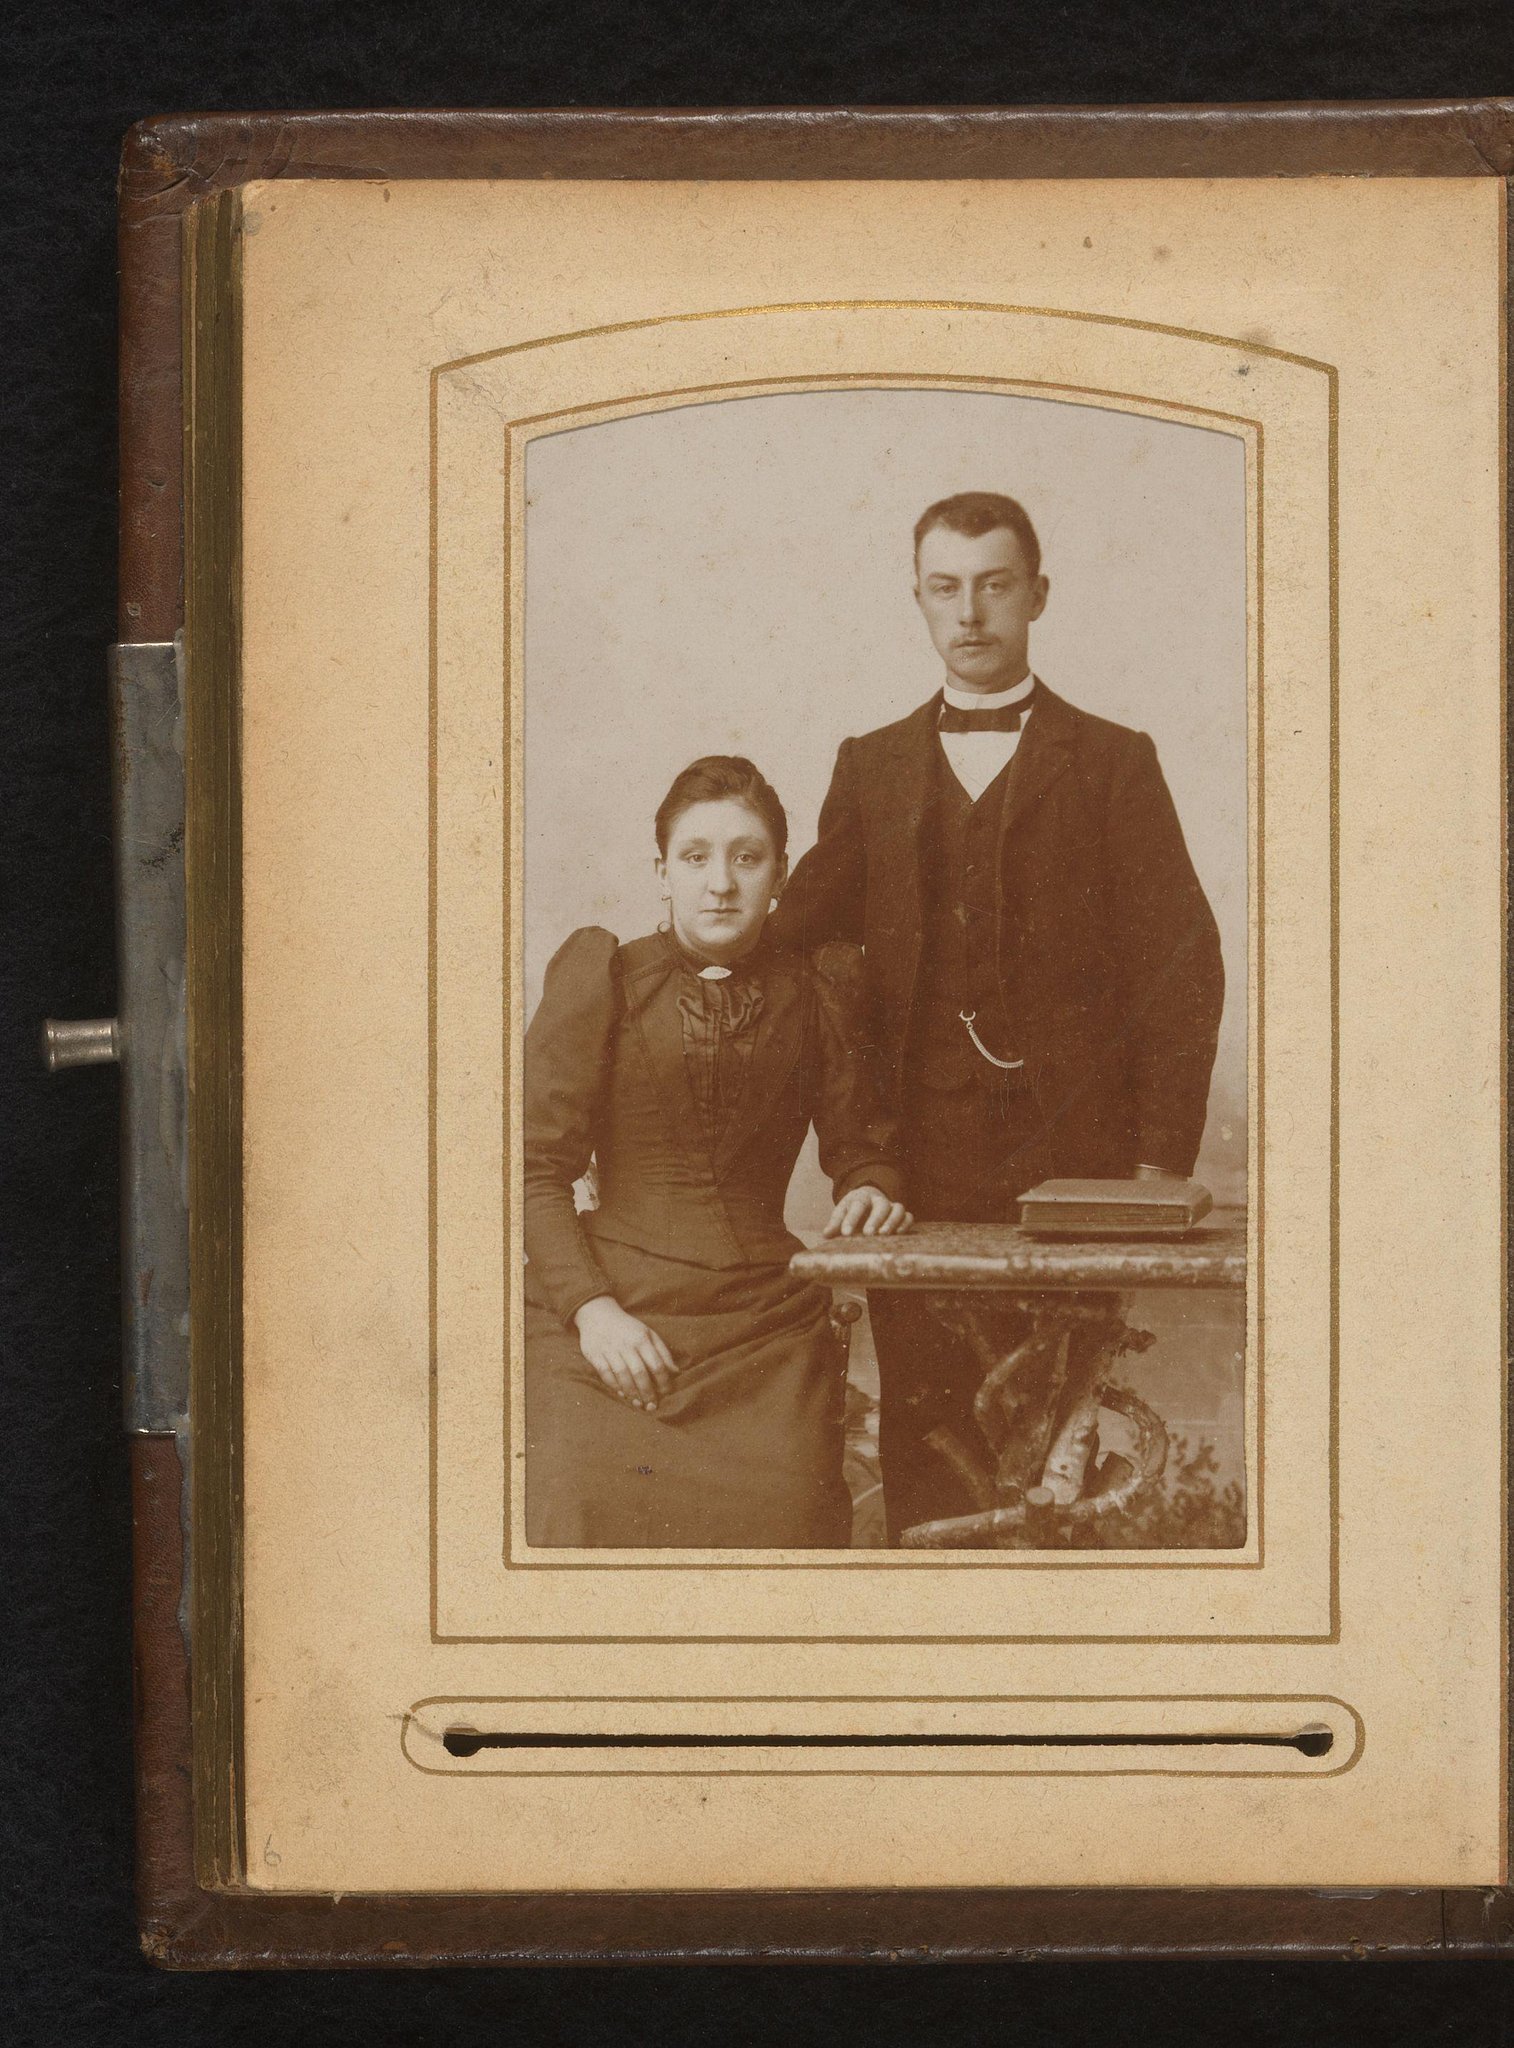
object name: carte de visite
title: Portret van een man en vrouw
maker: gustav johan erik jochmann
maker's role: fotograaf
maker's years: 1865-1941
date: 1892-1895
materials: cardboard, photographic support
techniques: collodion silver print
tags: adult woman, adult man, historical persons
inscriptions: inscription: ‘Photographic Atelier/ Gustaf Jochmann/ Oosthaven 18/ Gouda’